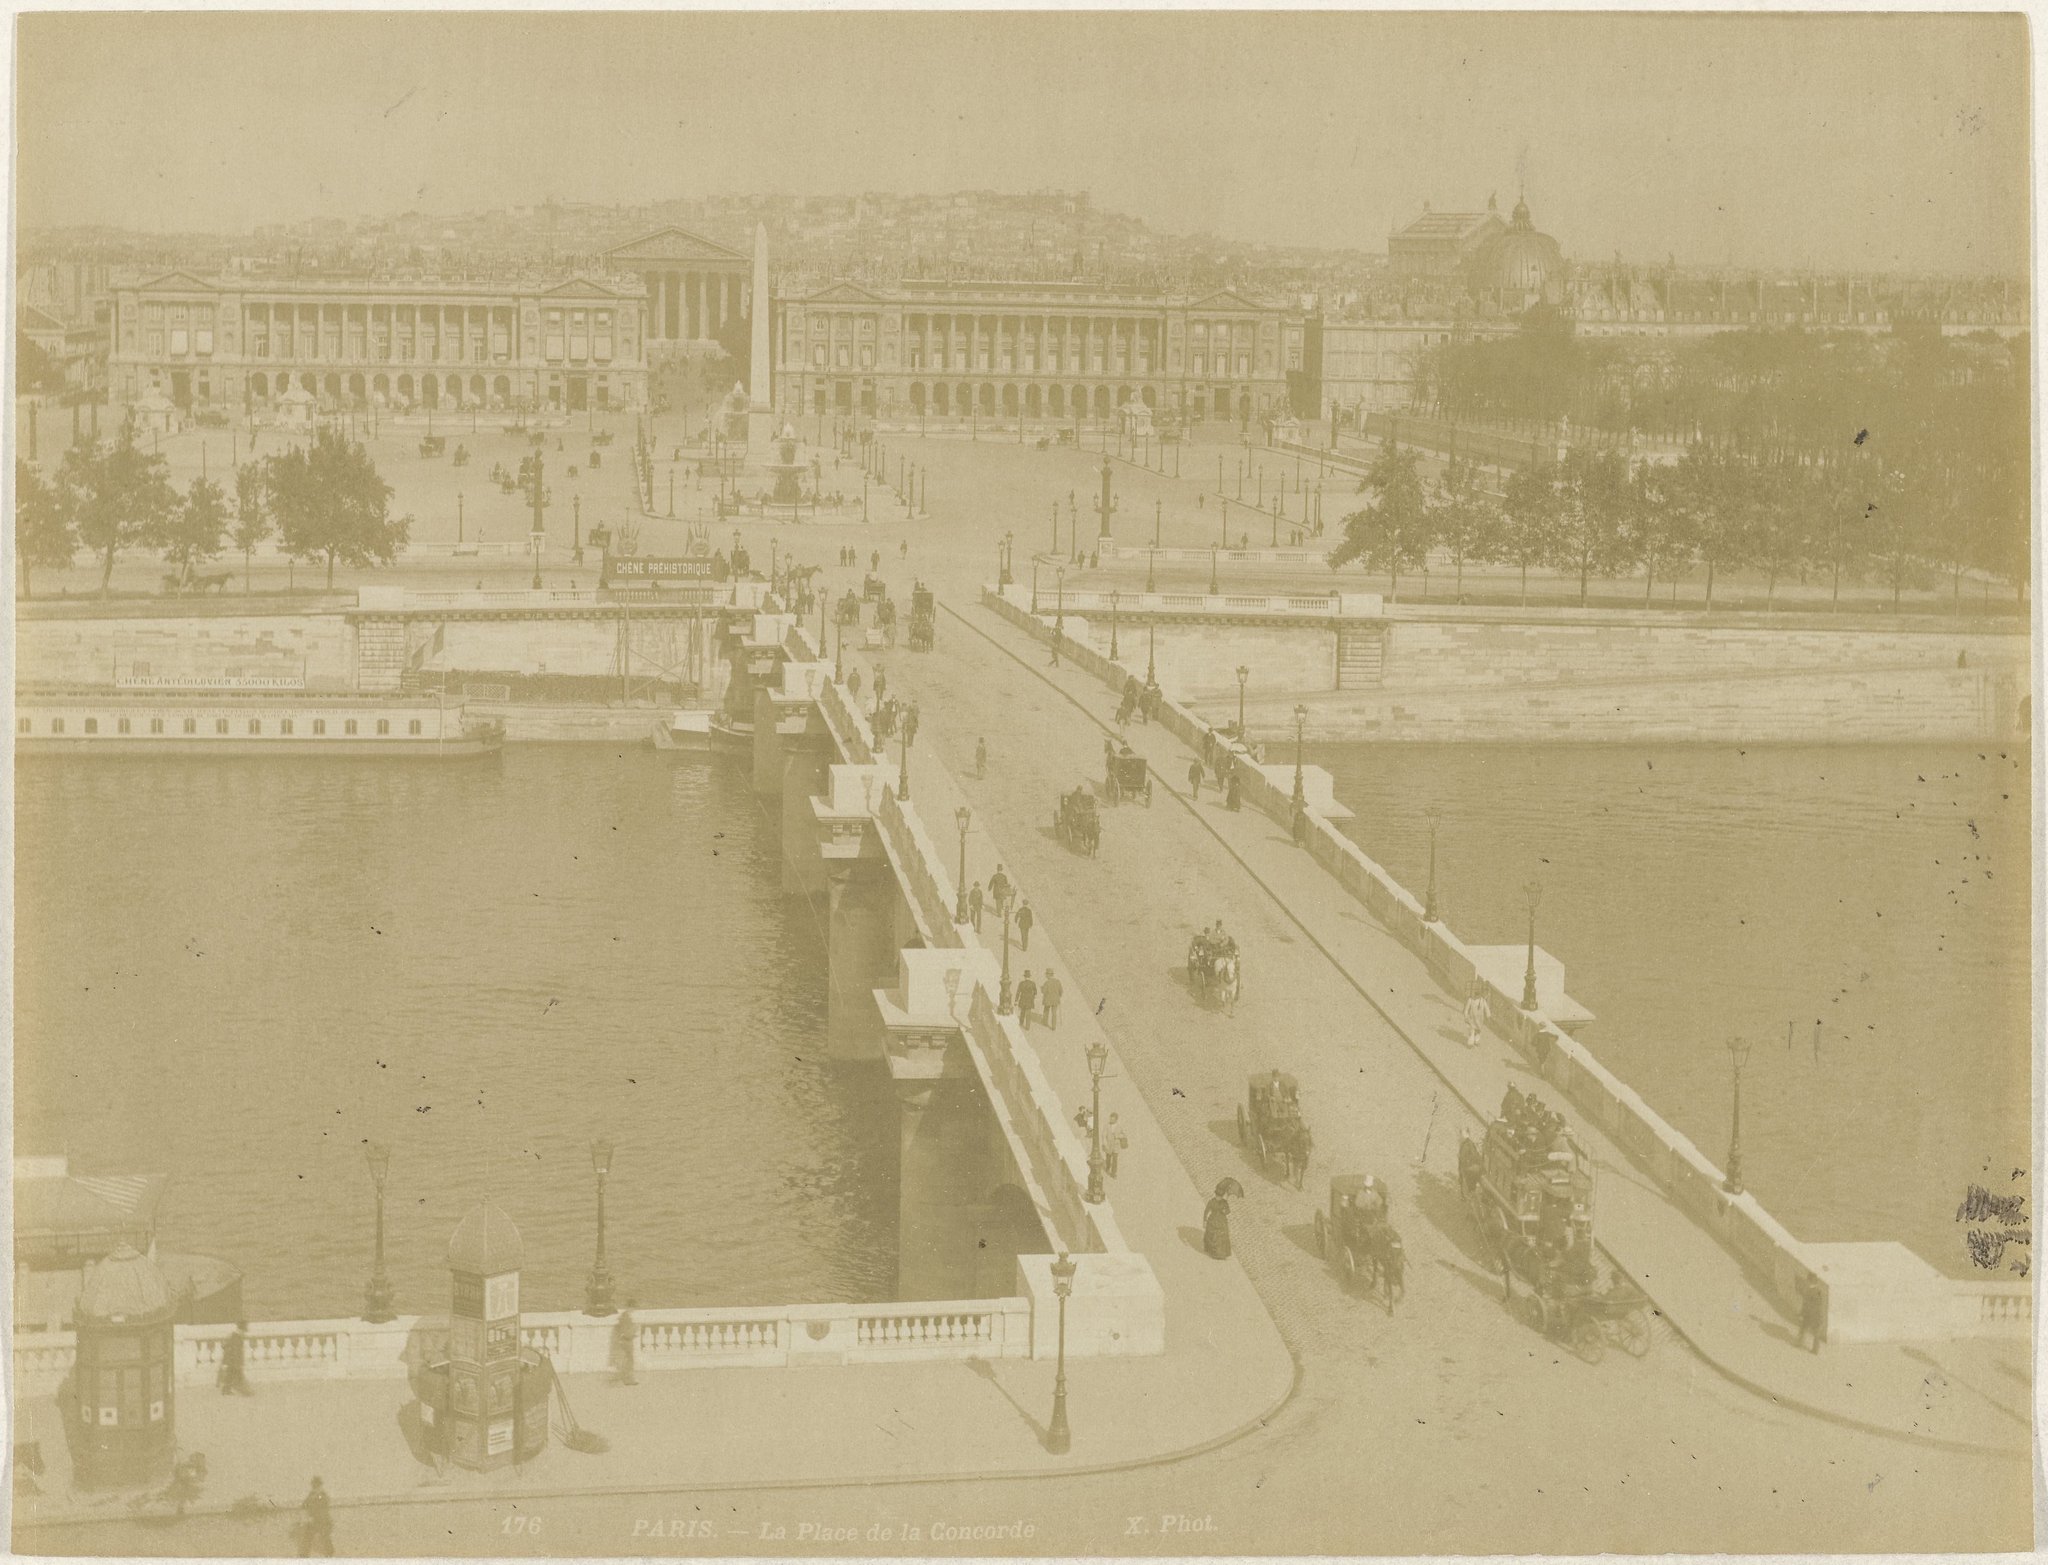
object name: photograph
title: Gezicht op de Pont de la Concorde over de Seine in Parijs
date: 1887-1900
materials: paper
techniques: albumen print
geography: paris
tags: bridge in city across river, canal, etc.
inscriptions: number: ‘176’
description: Tussen 1887 en ca. 1900 werkten Neurdein frères onder andere onder de naam 'X phot.'.